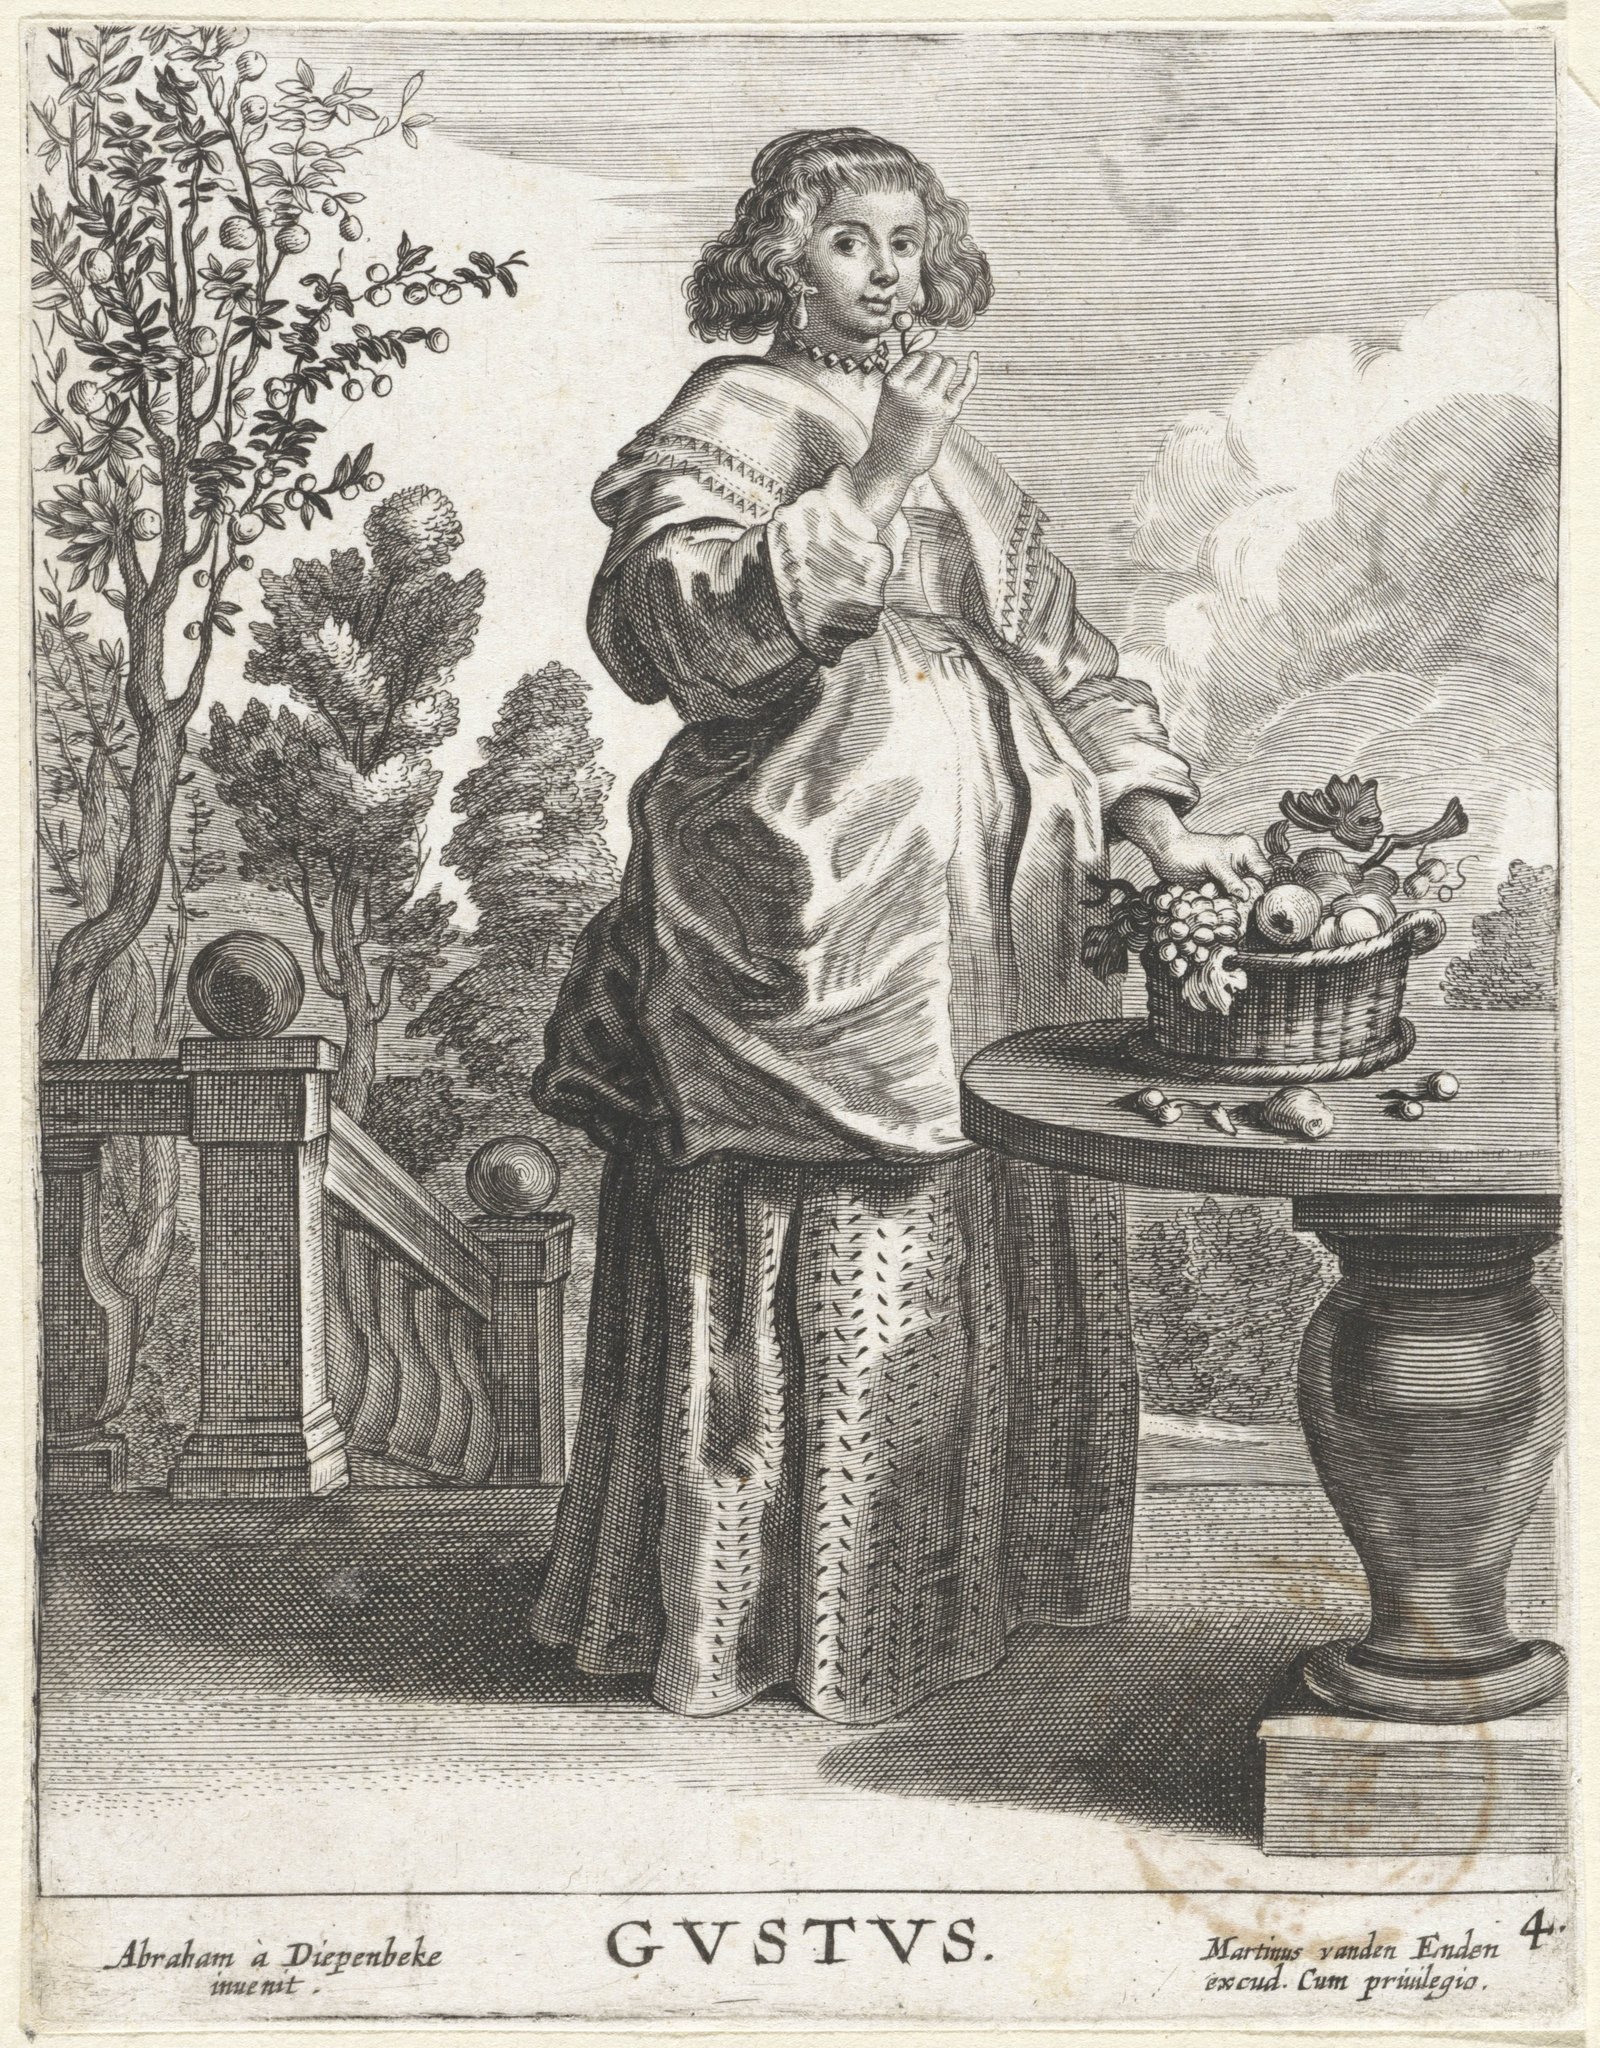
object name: print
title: Vijf zintuigen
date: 1630-1654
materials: paper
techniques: engraving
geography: antwerp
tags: taste, tasting (one of the five senses) - aa - female human figure, fruits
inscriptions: collector's mark: Lugt 240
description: Personificatie van het zintuig Smaak. Een vrouw eet fruit uit de fruitmand die voor haar op tafel staat.